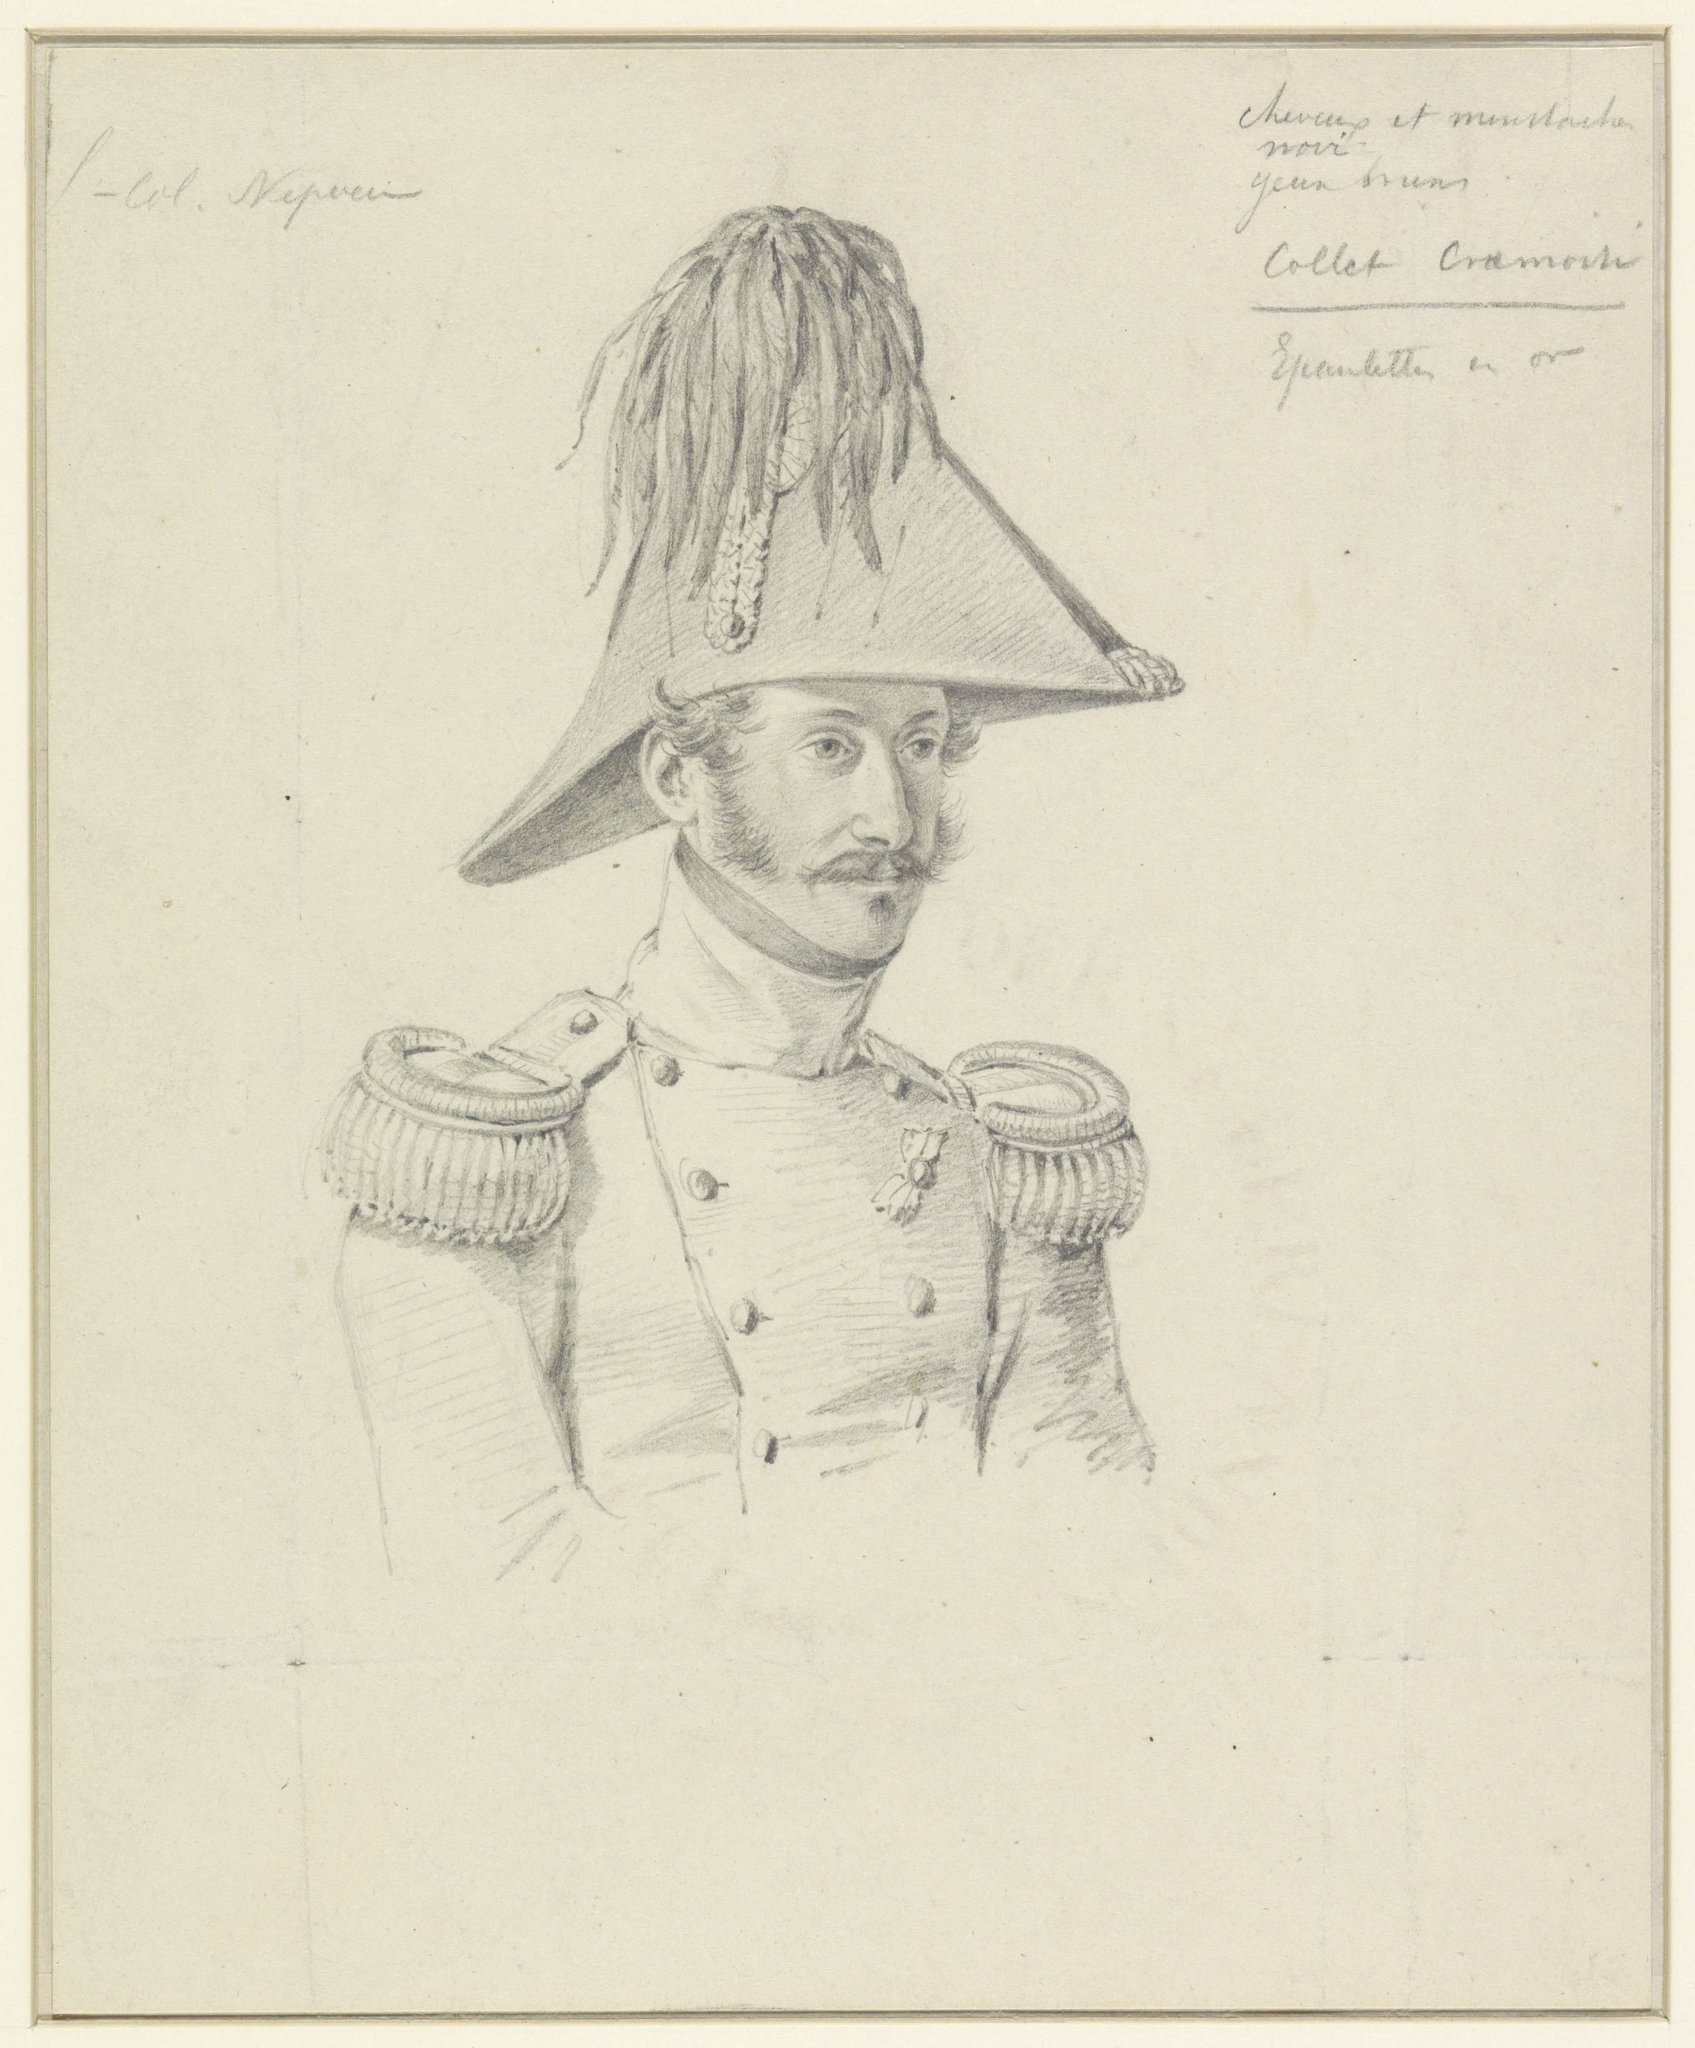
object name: drawing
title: Portret van Luitenant-Kolonel Nepveu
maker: jacob joseph eeckhout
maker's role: draughtsman, print maker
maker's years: 1793-1861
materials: paper, pencil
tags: politician, historical persons, officer (lieutenant-colonel)